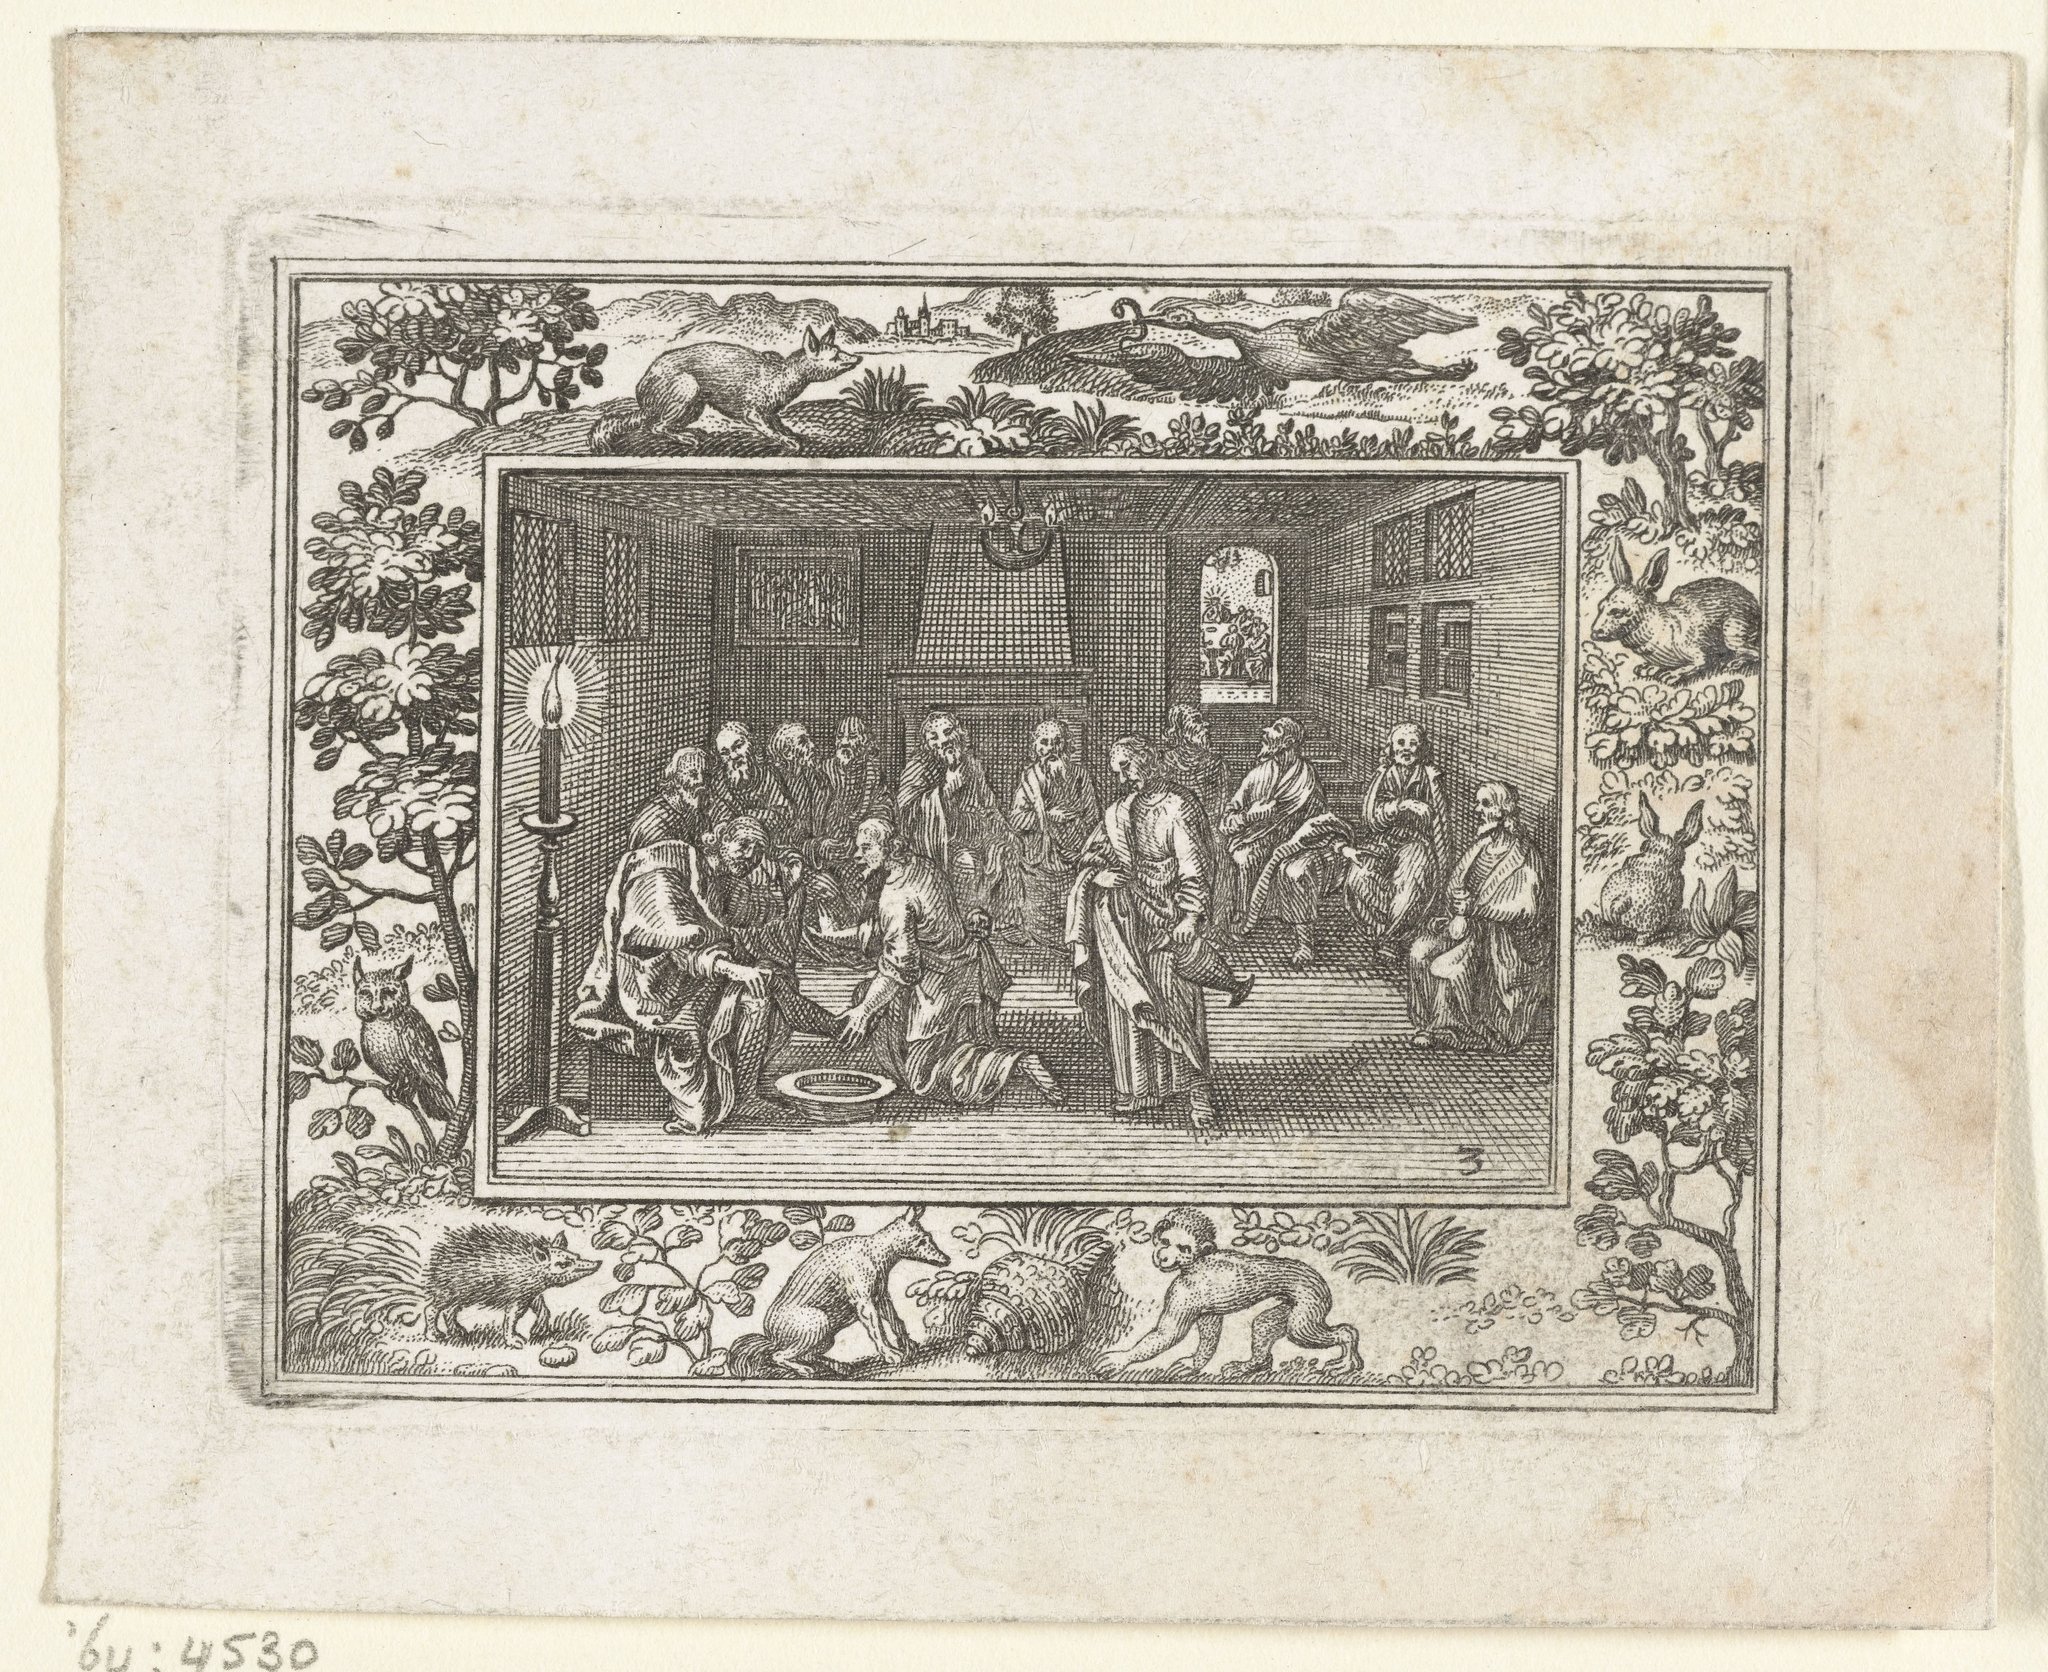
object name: print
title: Passievoorstellingen in lijsten met dieren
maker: Anonymous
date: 1600-1699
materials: paper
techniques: etching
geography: germany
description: Linksonder loopt een stekelvarken, midden onder zitten een vos en een aap naast een schelp.